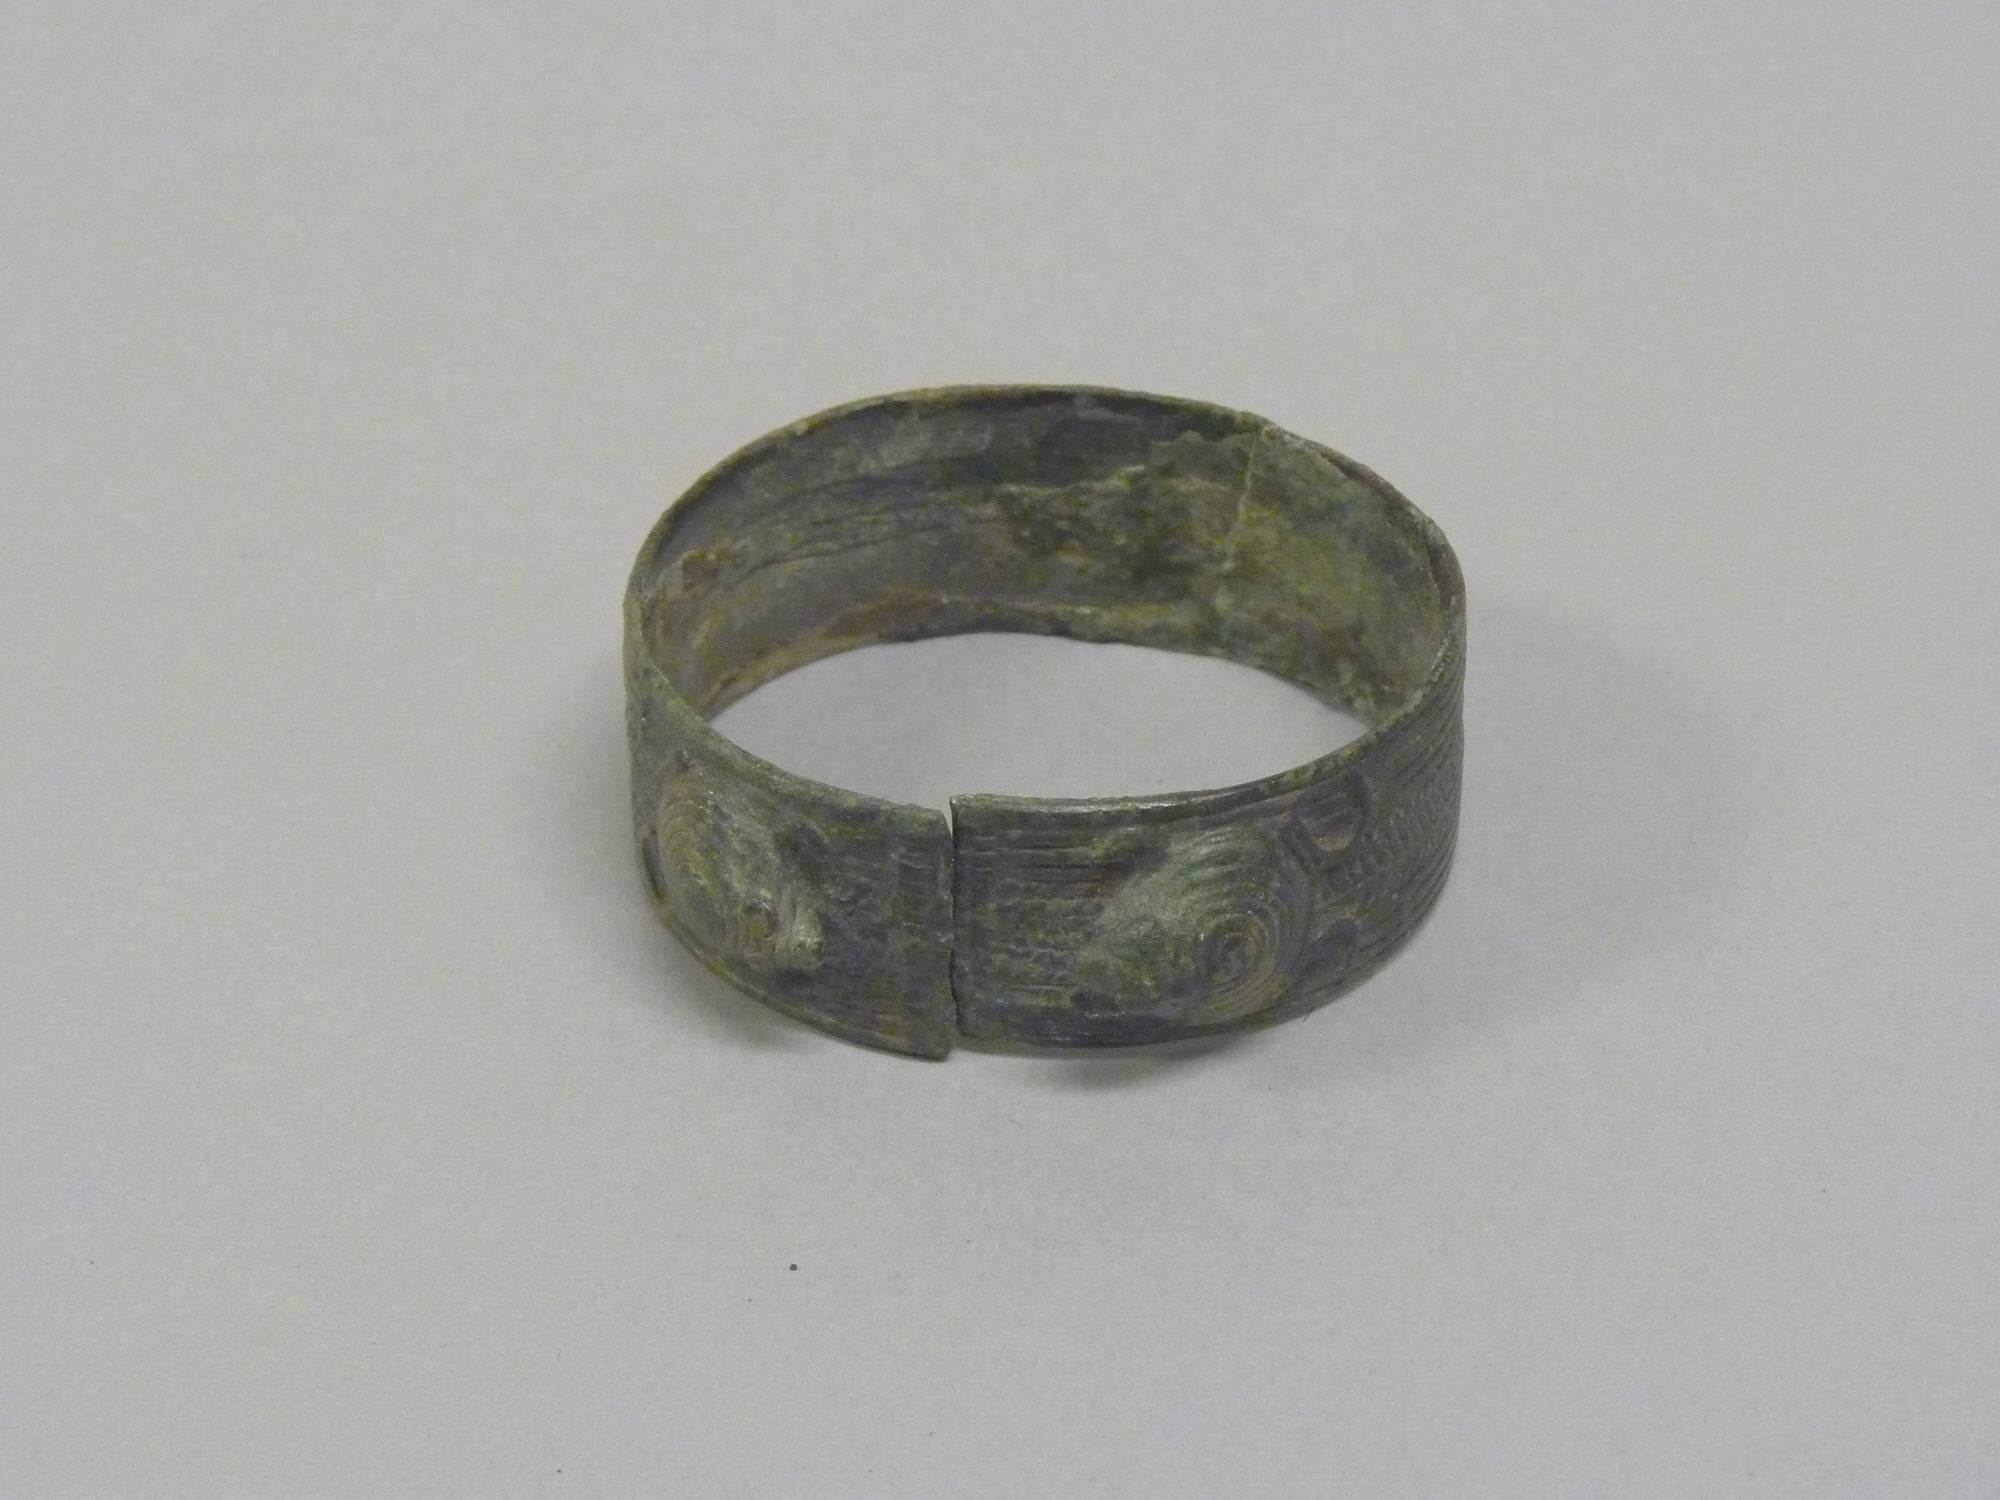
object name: bracelet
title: Bracelet with Two Facing Frogs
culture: thai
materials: bronze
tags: frogs